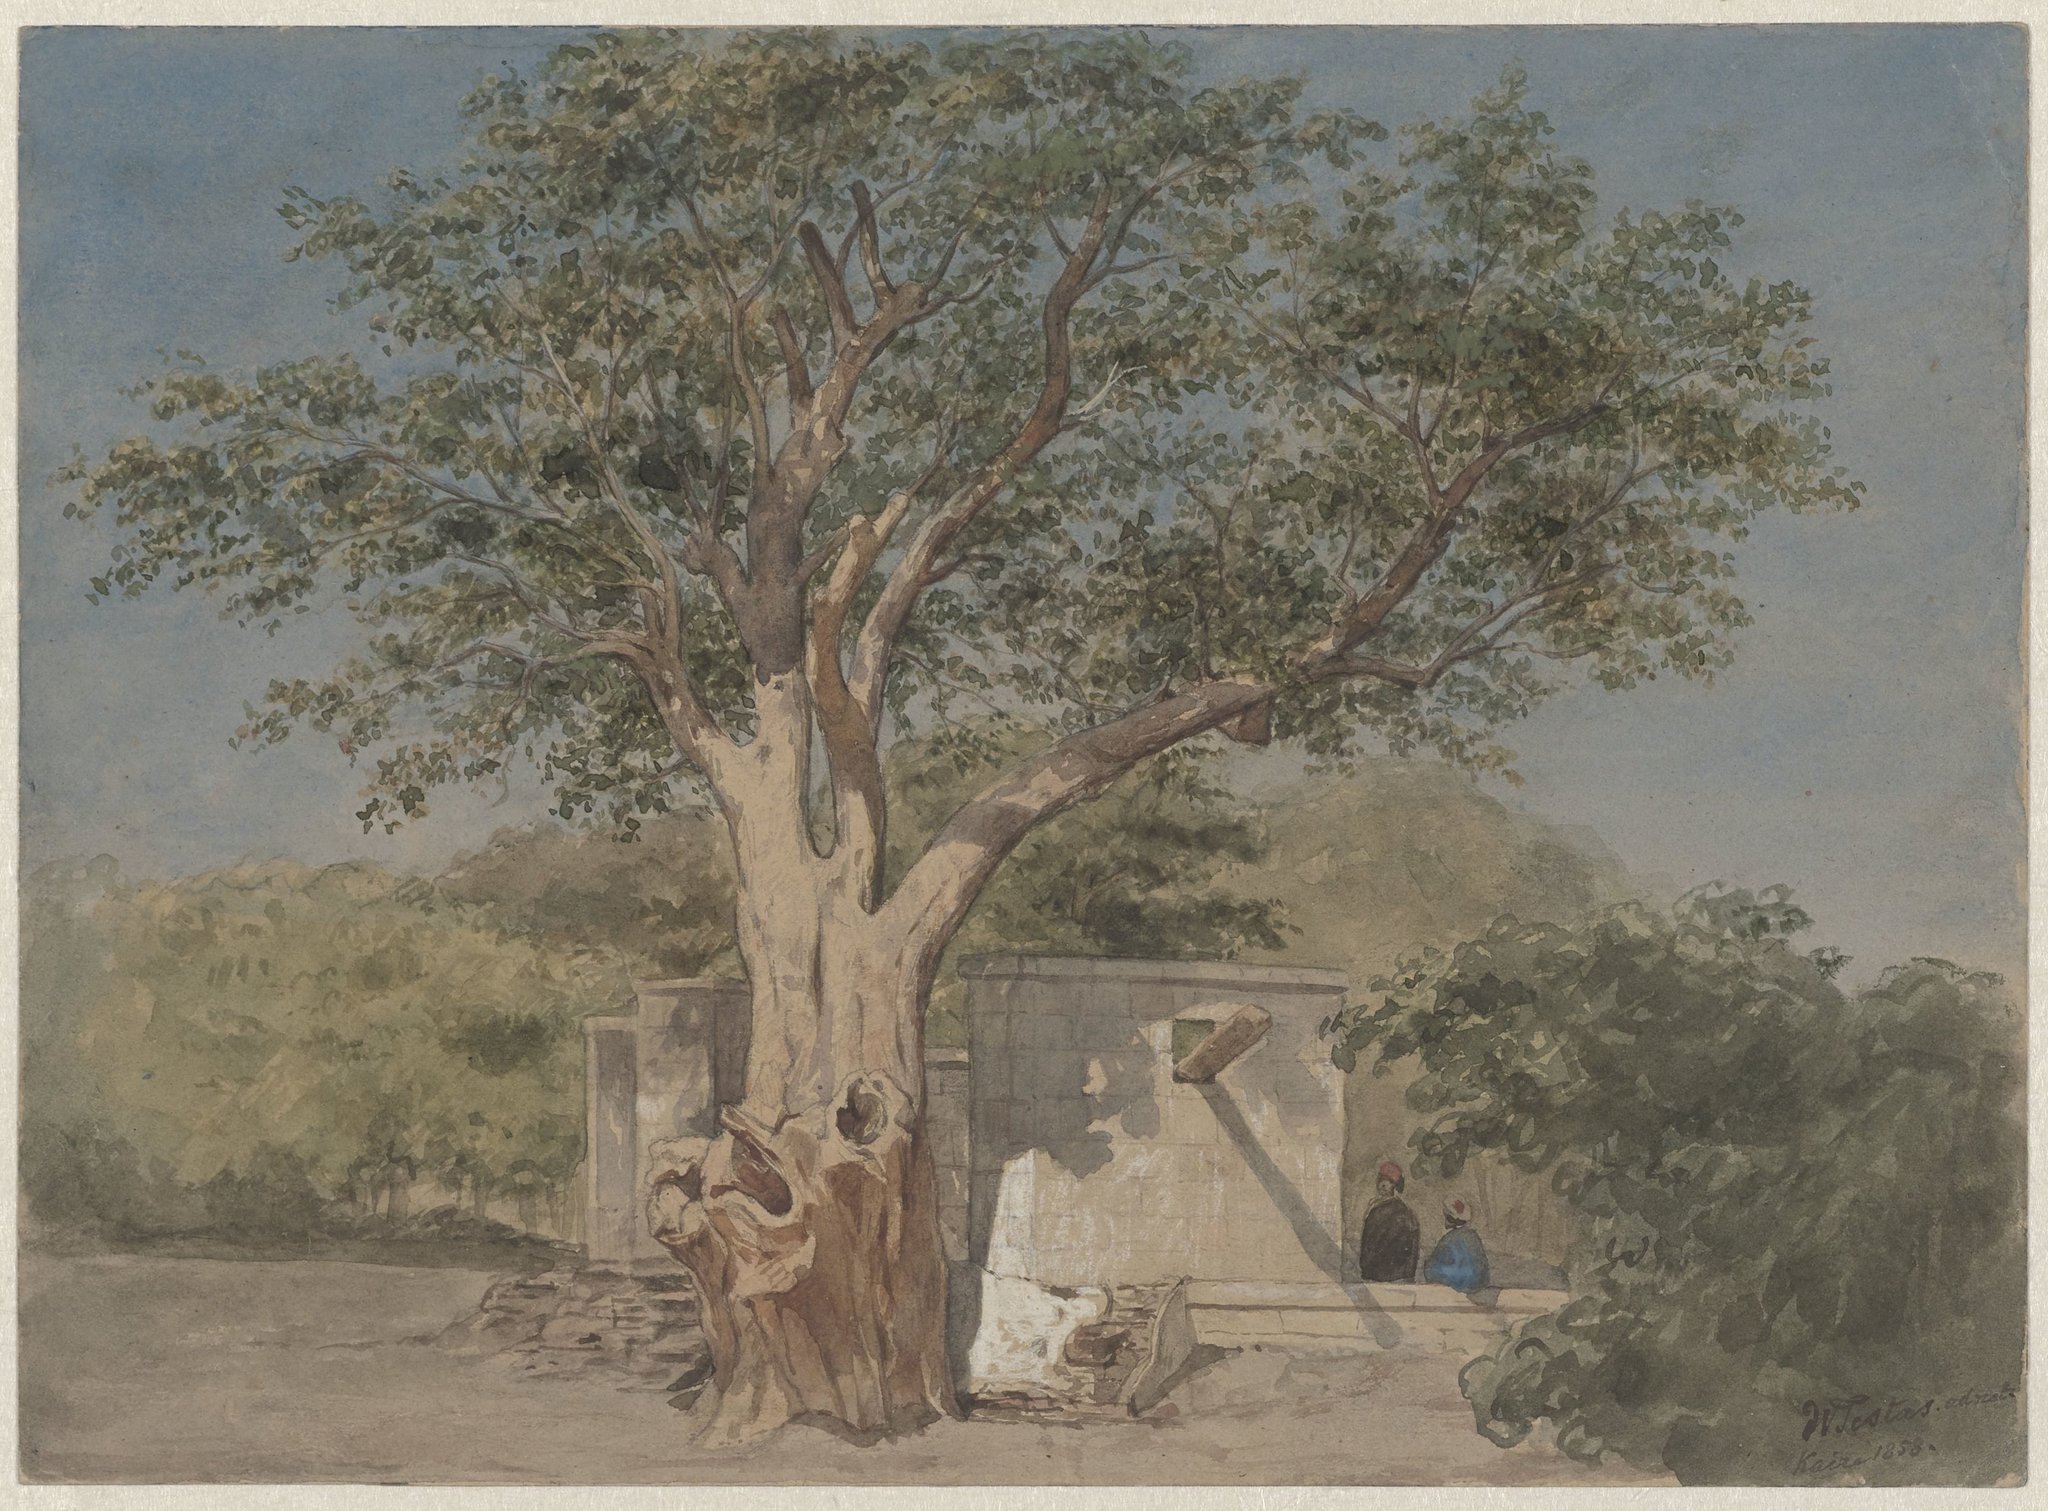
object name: drawing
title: Hutje onder boom te Kaïro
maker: willem de famars testas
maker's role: draughtsman, painter, print maker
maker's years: 1834-1896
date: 1858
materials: paper, pencil, watercolor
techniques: brush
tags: hut, cabin, lodge, asiatic races and peoples (with name)